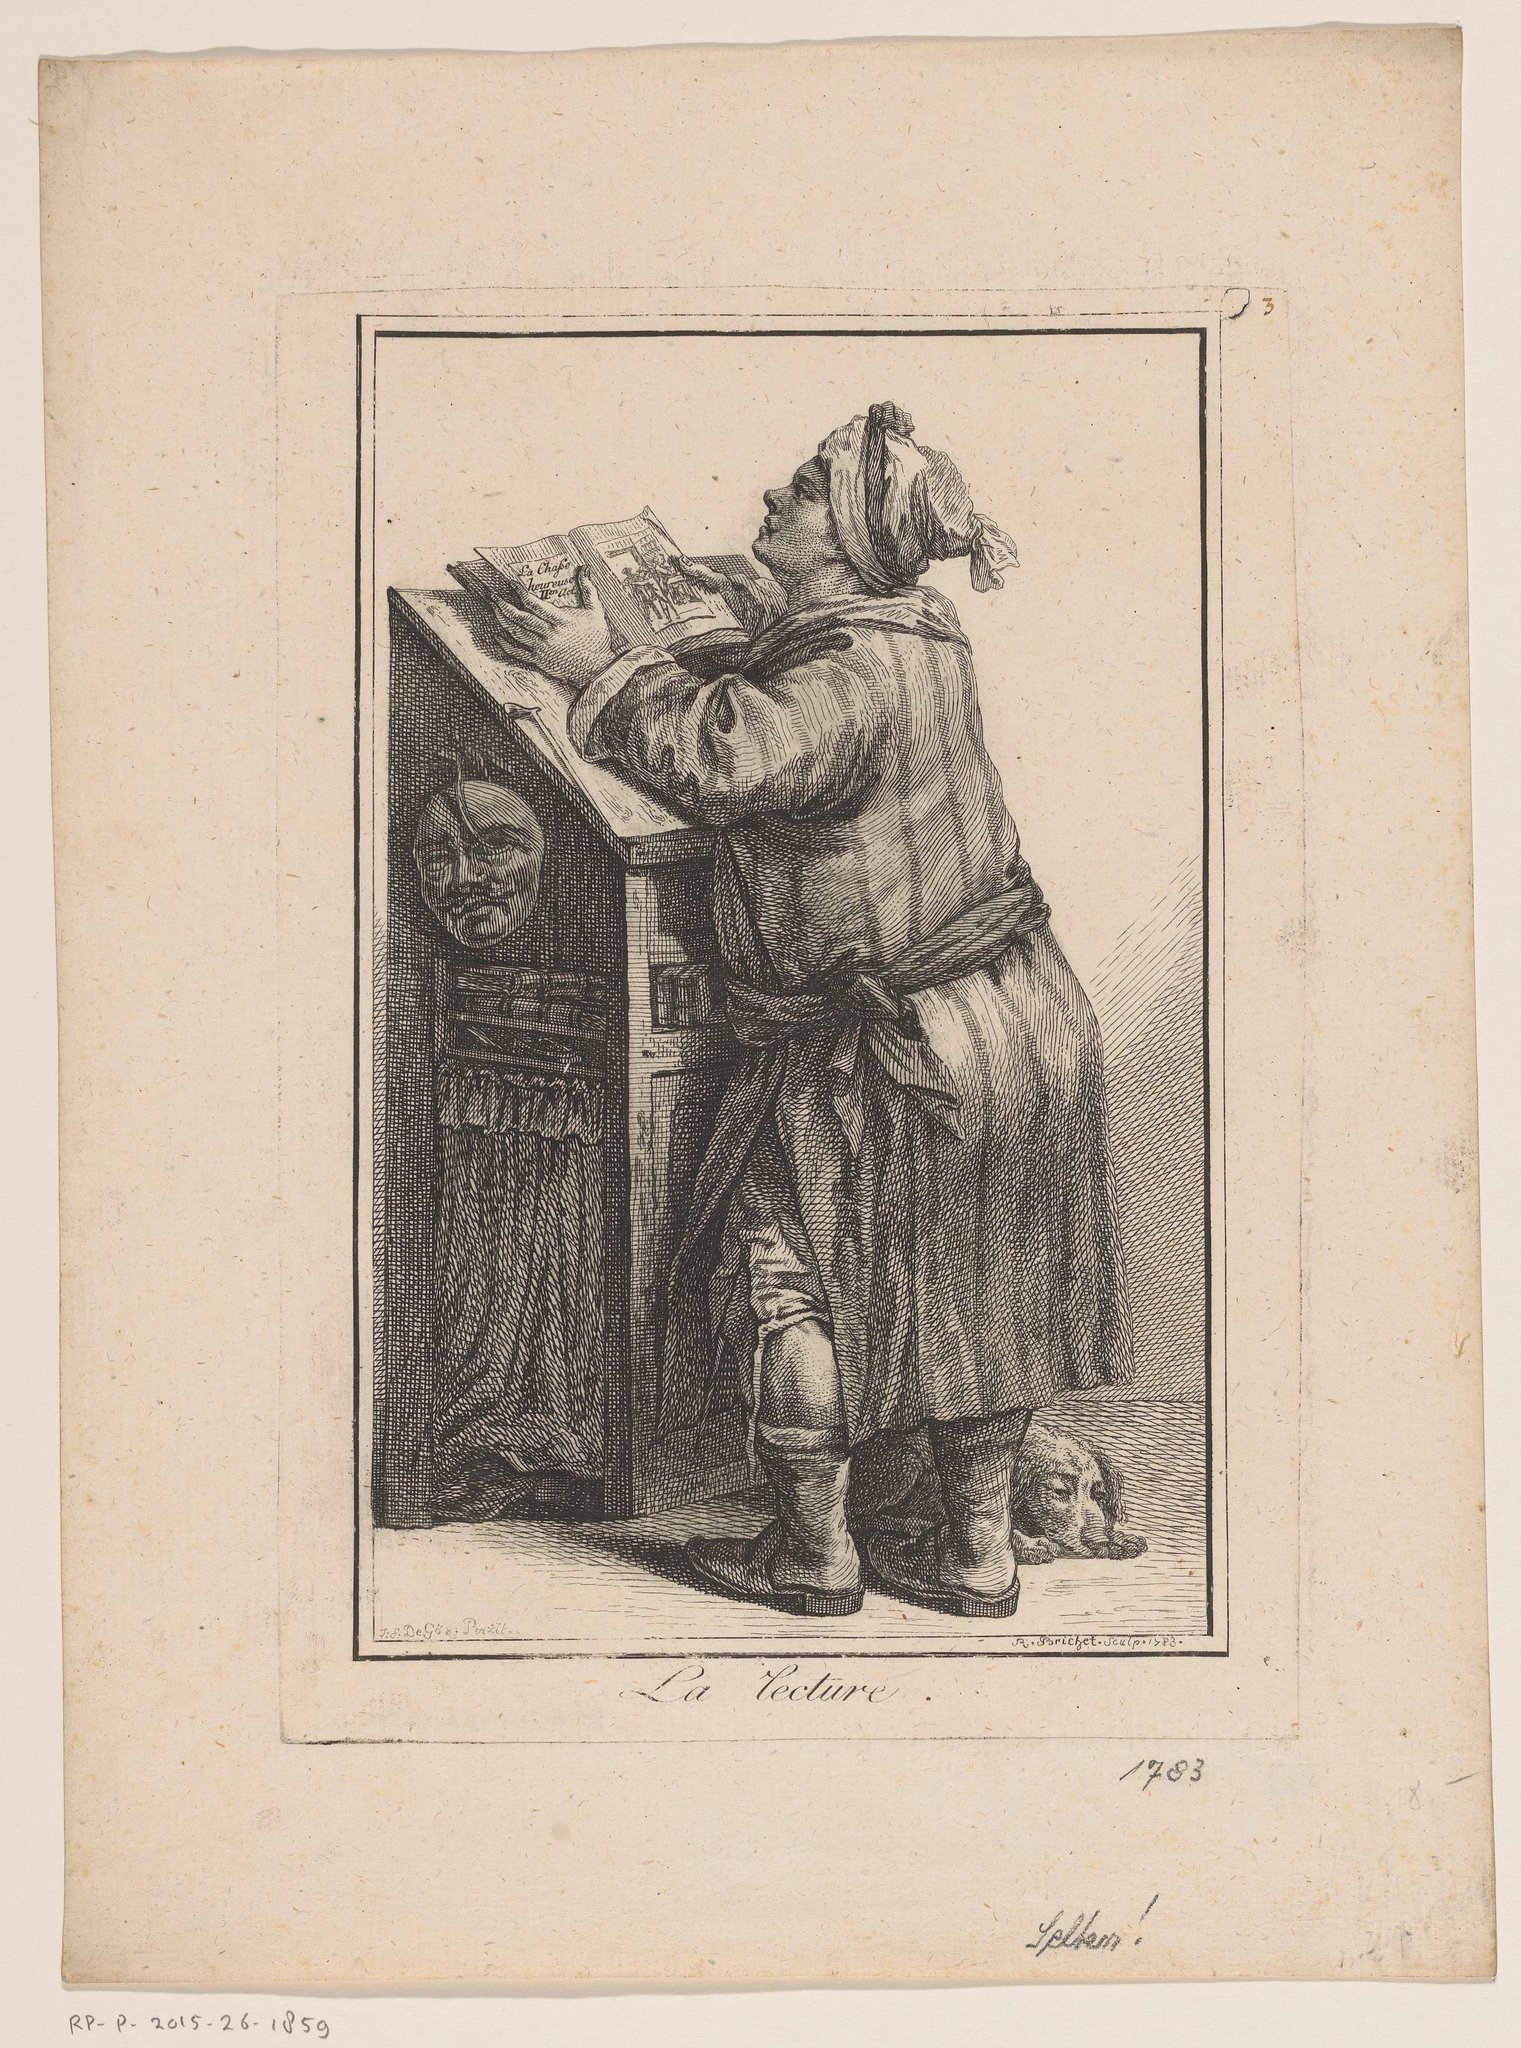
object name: print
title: La lecture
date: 1783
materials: paper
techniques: etching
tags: reading, lectern ~ reading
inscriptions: number: ‘3’, collector's mark: Lugt 4779, collector's mark: Lugt 4780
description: Man in kamerjas en muts op het hoofd, staand voor lezenaar. Hij leest een boek getiteld 'La Chasse heureuse'. Aan de zijkant van de lezenaar hangt een masker. Aan de voeten van de man slaapt een hond.